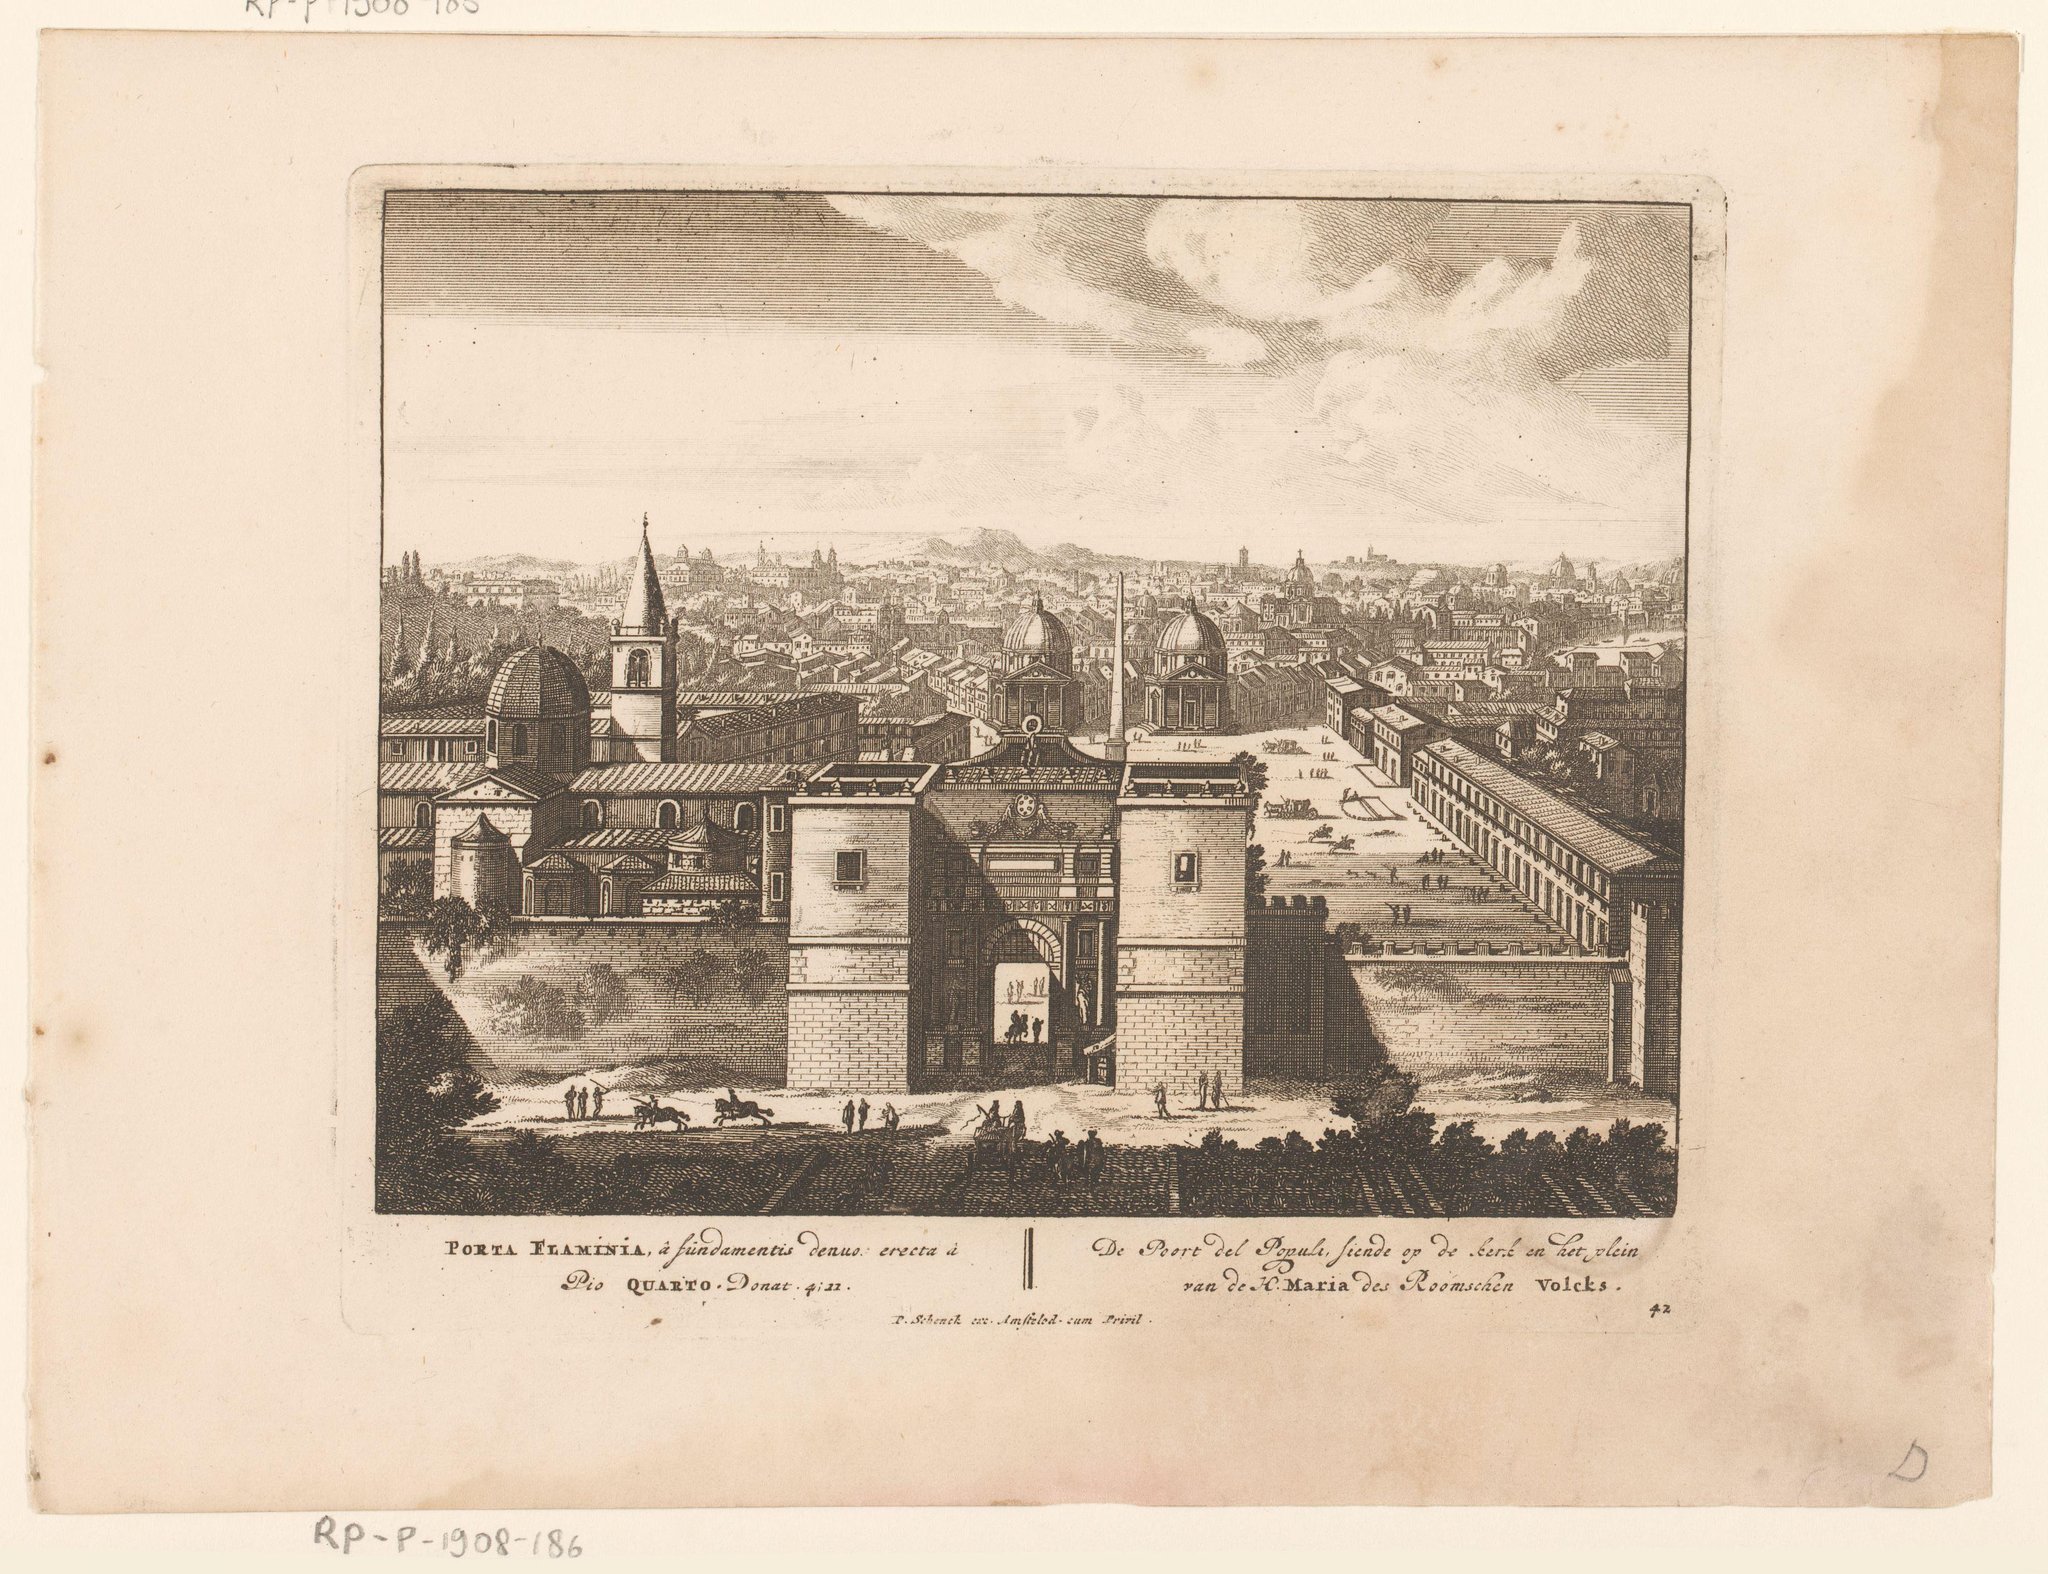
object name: print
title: Gezicht op de Porta del Popolo, te Rome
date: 1705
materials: paper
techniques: engraving, etching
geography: amsterdam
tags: city-gate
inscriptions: collector's mark: Lugt 2228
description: Prent ook gebruikt in: Schenck, Pieter. Roma aeterna Petri Schenkii, sive, ipsius Aedificiorum romanorum, integrorum collapsorumque (...). Amsterdam: Pieter Schenck (I), 1705.